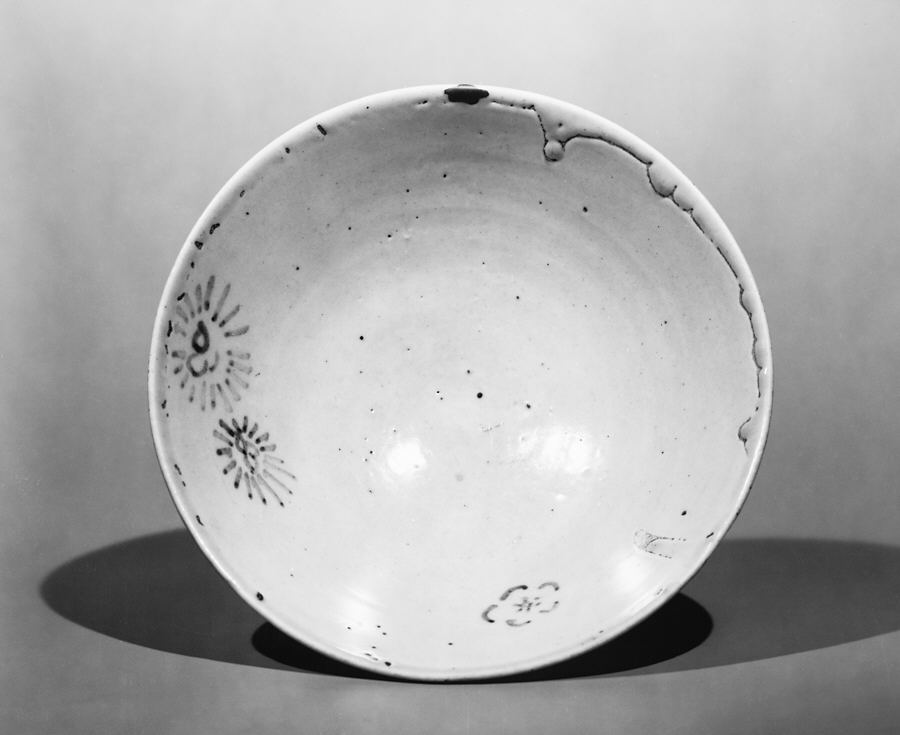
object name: bowl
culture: japanese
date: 1615-1868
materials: porcelain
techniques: underglaze